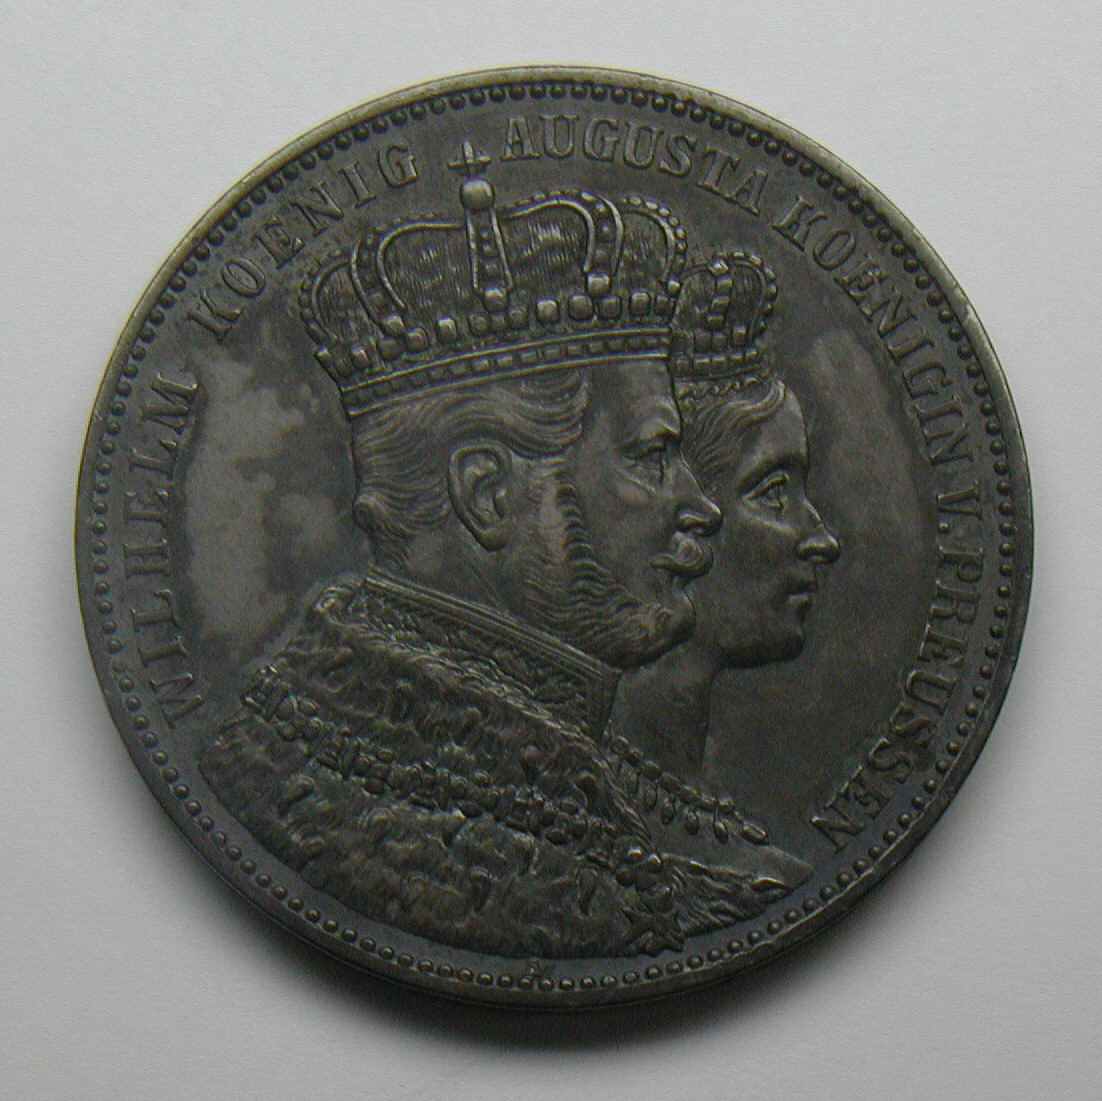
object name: thaler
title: Coronation thaler of King William I and Queen Augusta of Prussia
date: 1861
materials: silver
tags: kings,profiles,coat of arms